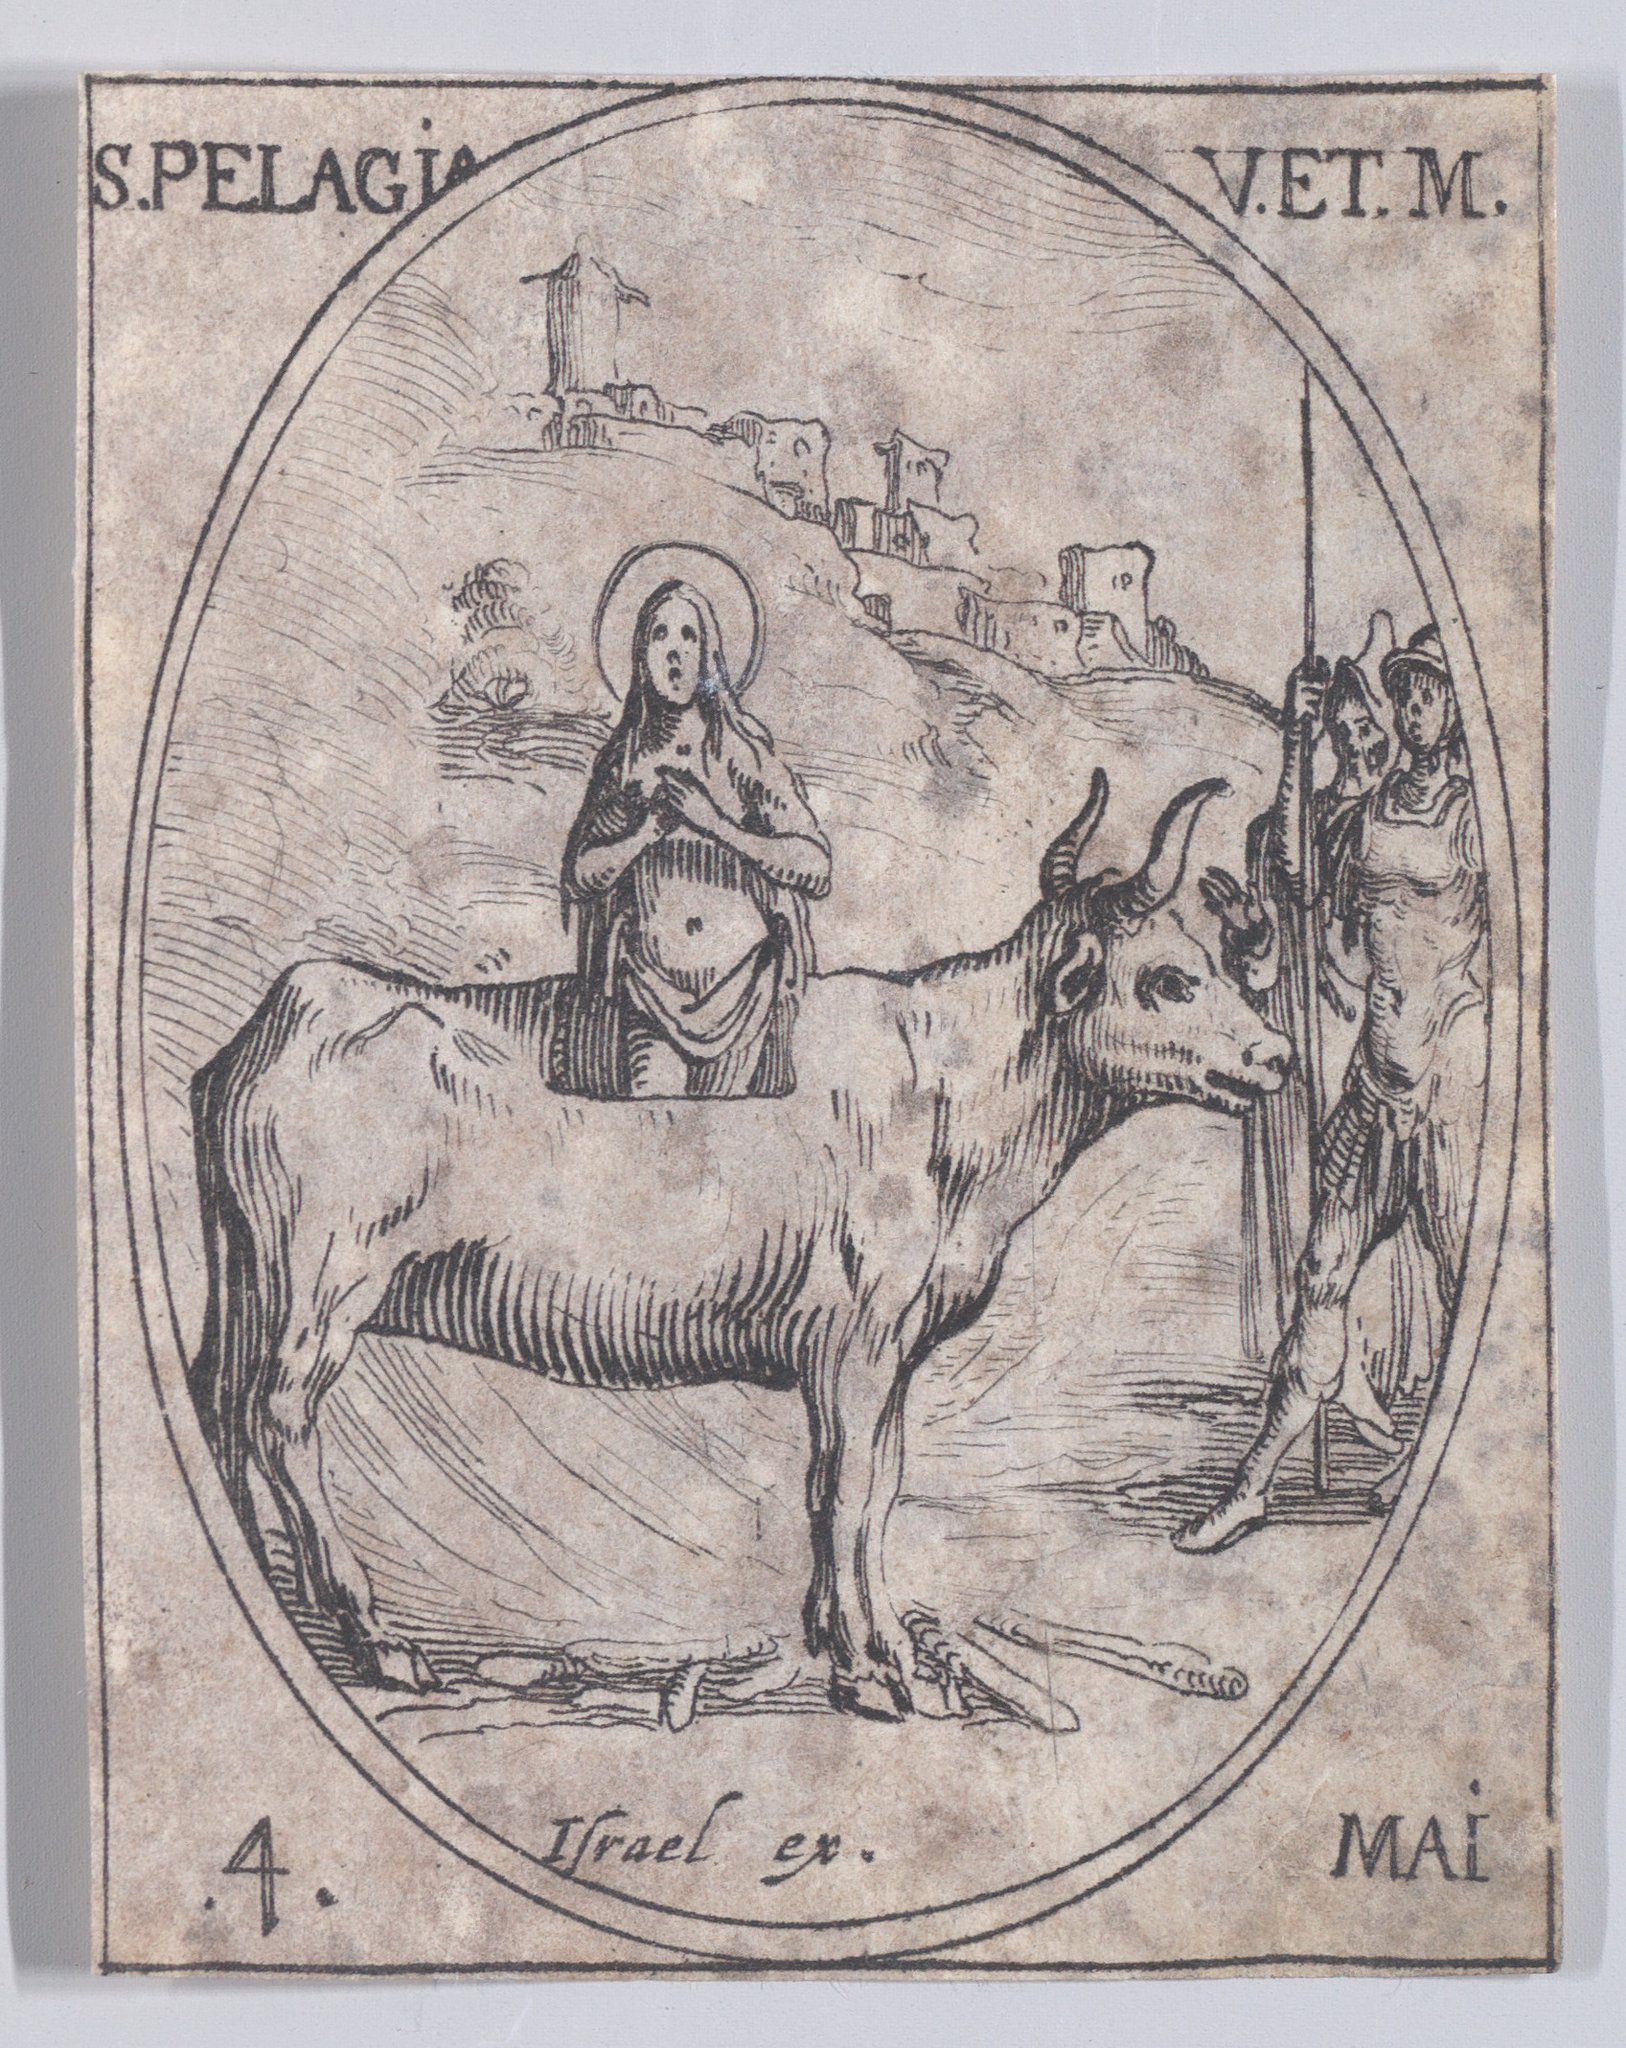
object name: print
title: Ste. Pélagie, vierge et martyre (St. Pelagia, Virgin and Martyr), May 4th, from "Les Images De Tous Les Saincts et Saintes de L'Année" (Images of All of the Saints and Religious Events of the Year)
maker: jacques callot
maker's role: artist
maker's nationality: french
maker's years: 1592-1635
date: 1636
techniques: etching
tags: women,bulls,saints